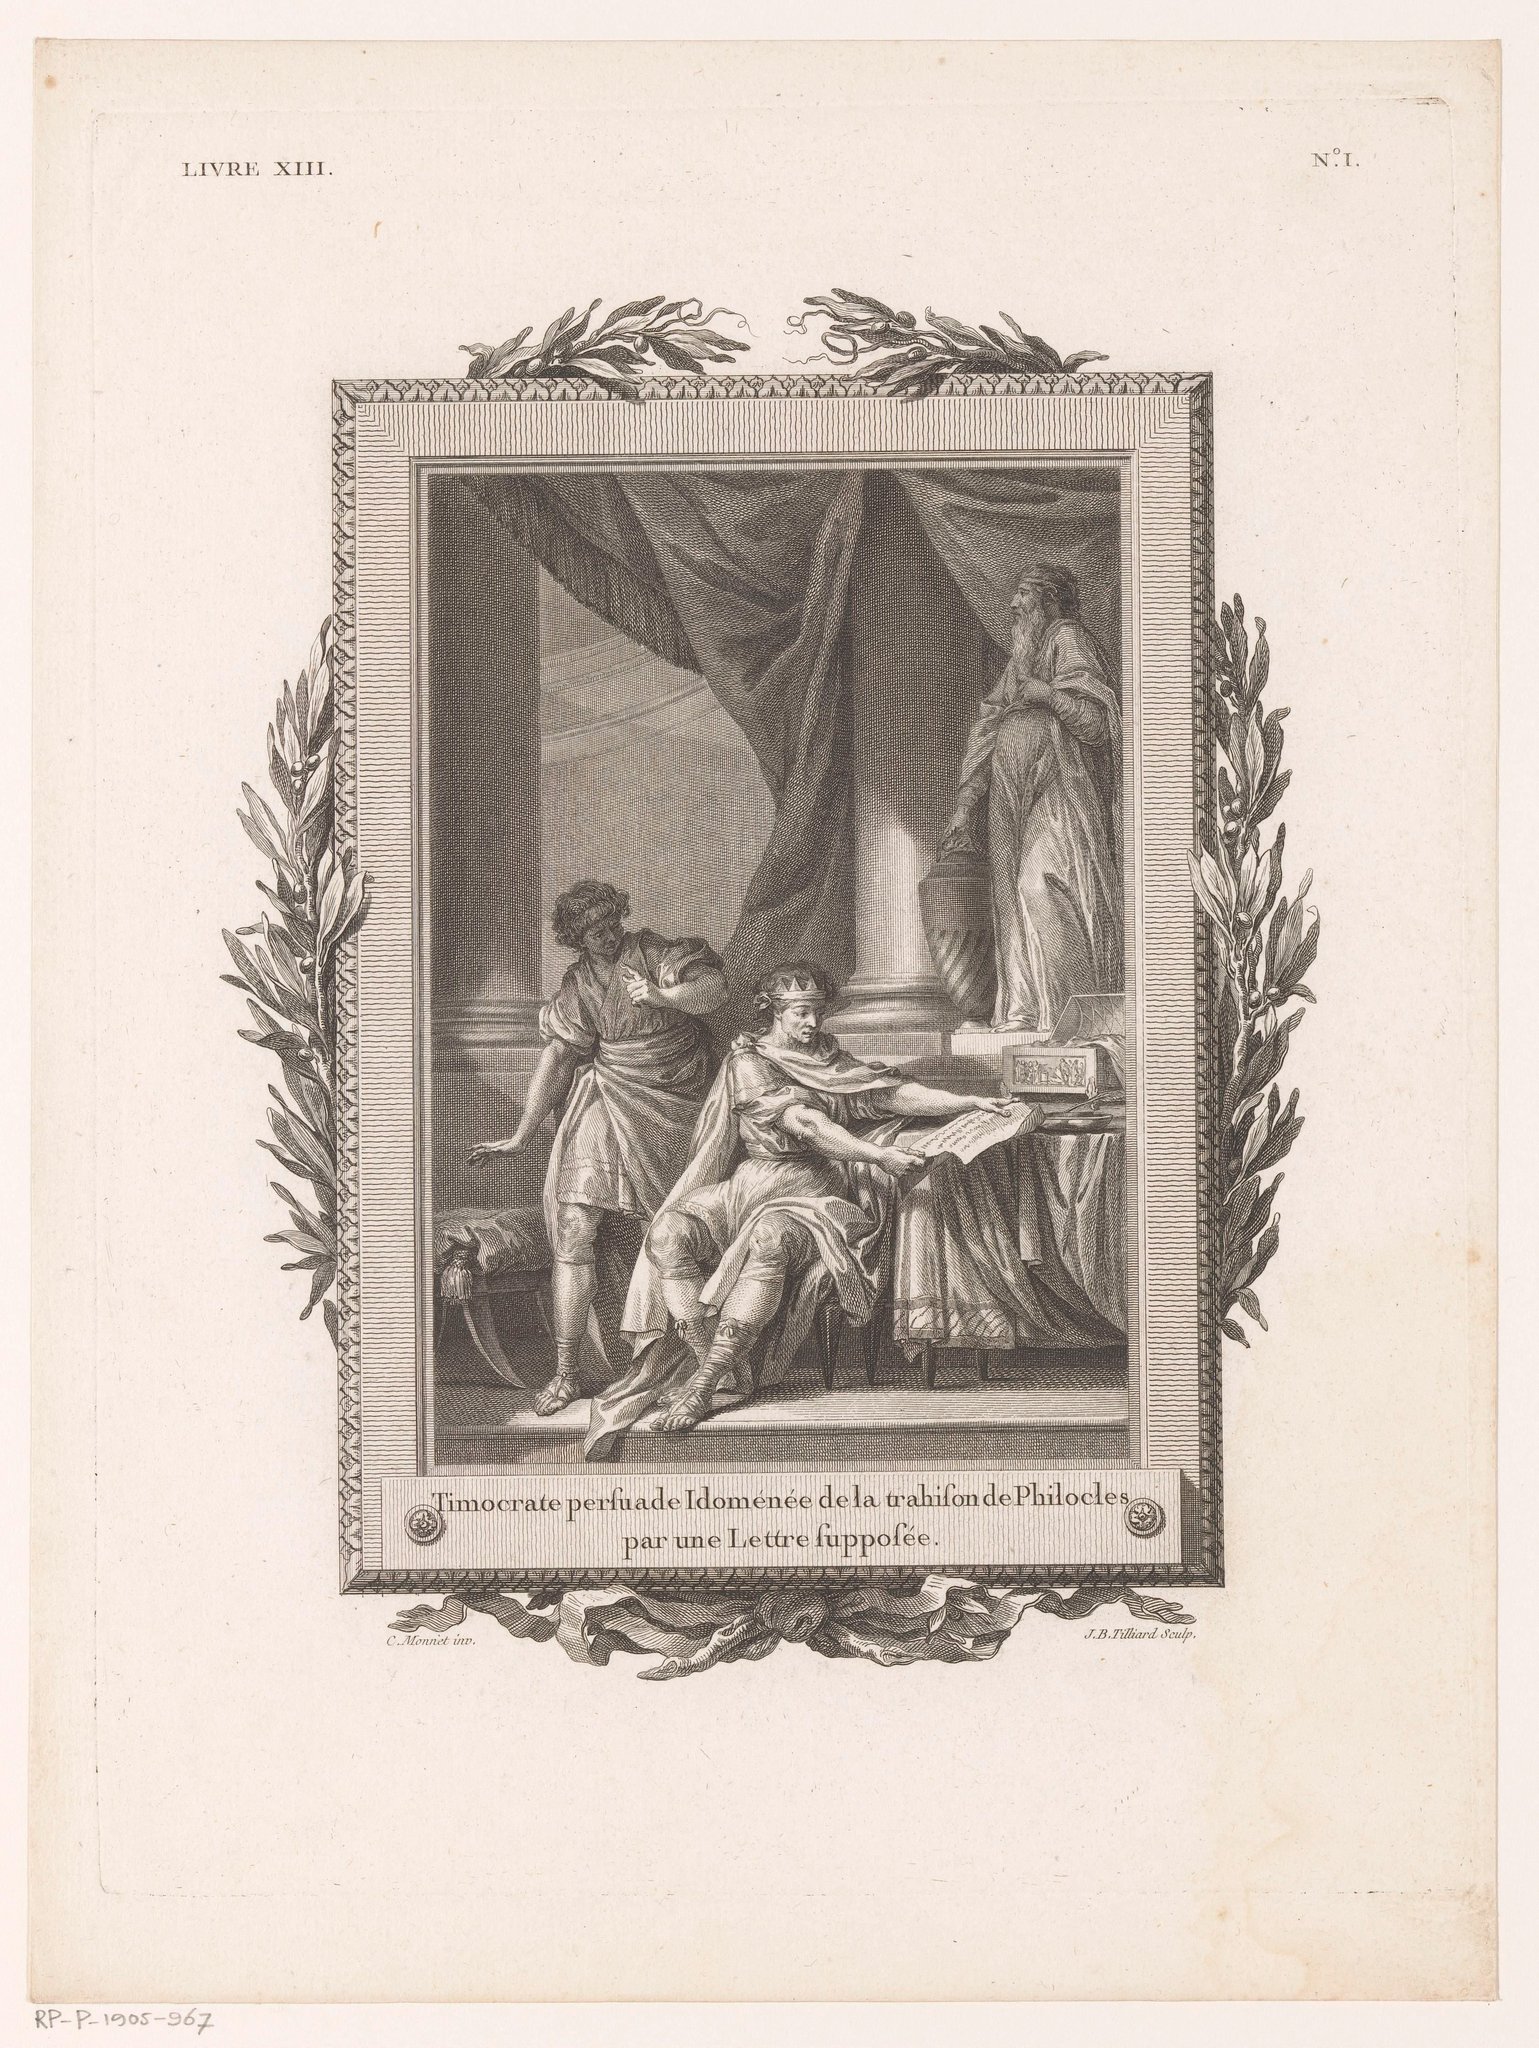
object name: book illustration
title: Timocrates overtuigt Idomeneus van het verraad van Philokles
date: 1785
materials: paper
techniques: engraving, etching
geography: paris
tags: (fenelon, telemachus) specific works of literature (with author, title), letter, envelope, ornament ~ festoon, garland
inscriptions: collector's mark: Lugt 2228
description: Idomeneus, gezeten aan een tafel, leest een brief. Naast hem staat Timocrates die hem overtuigt van het verraad van Philokles. Het geheel wordt gekaderd door een sierlijst met olijftakken en onderaan een strik. Genummerd rechtsboven: No. I.